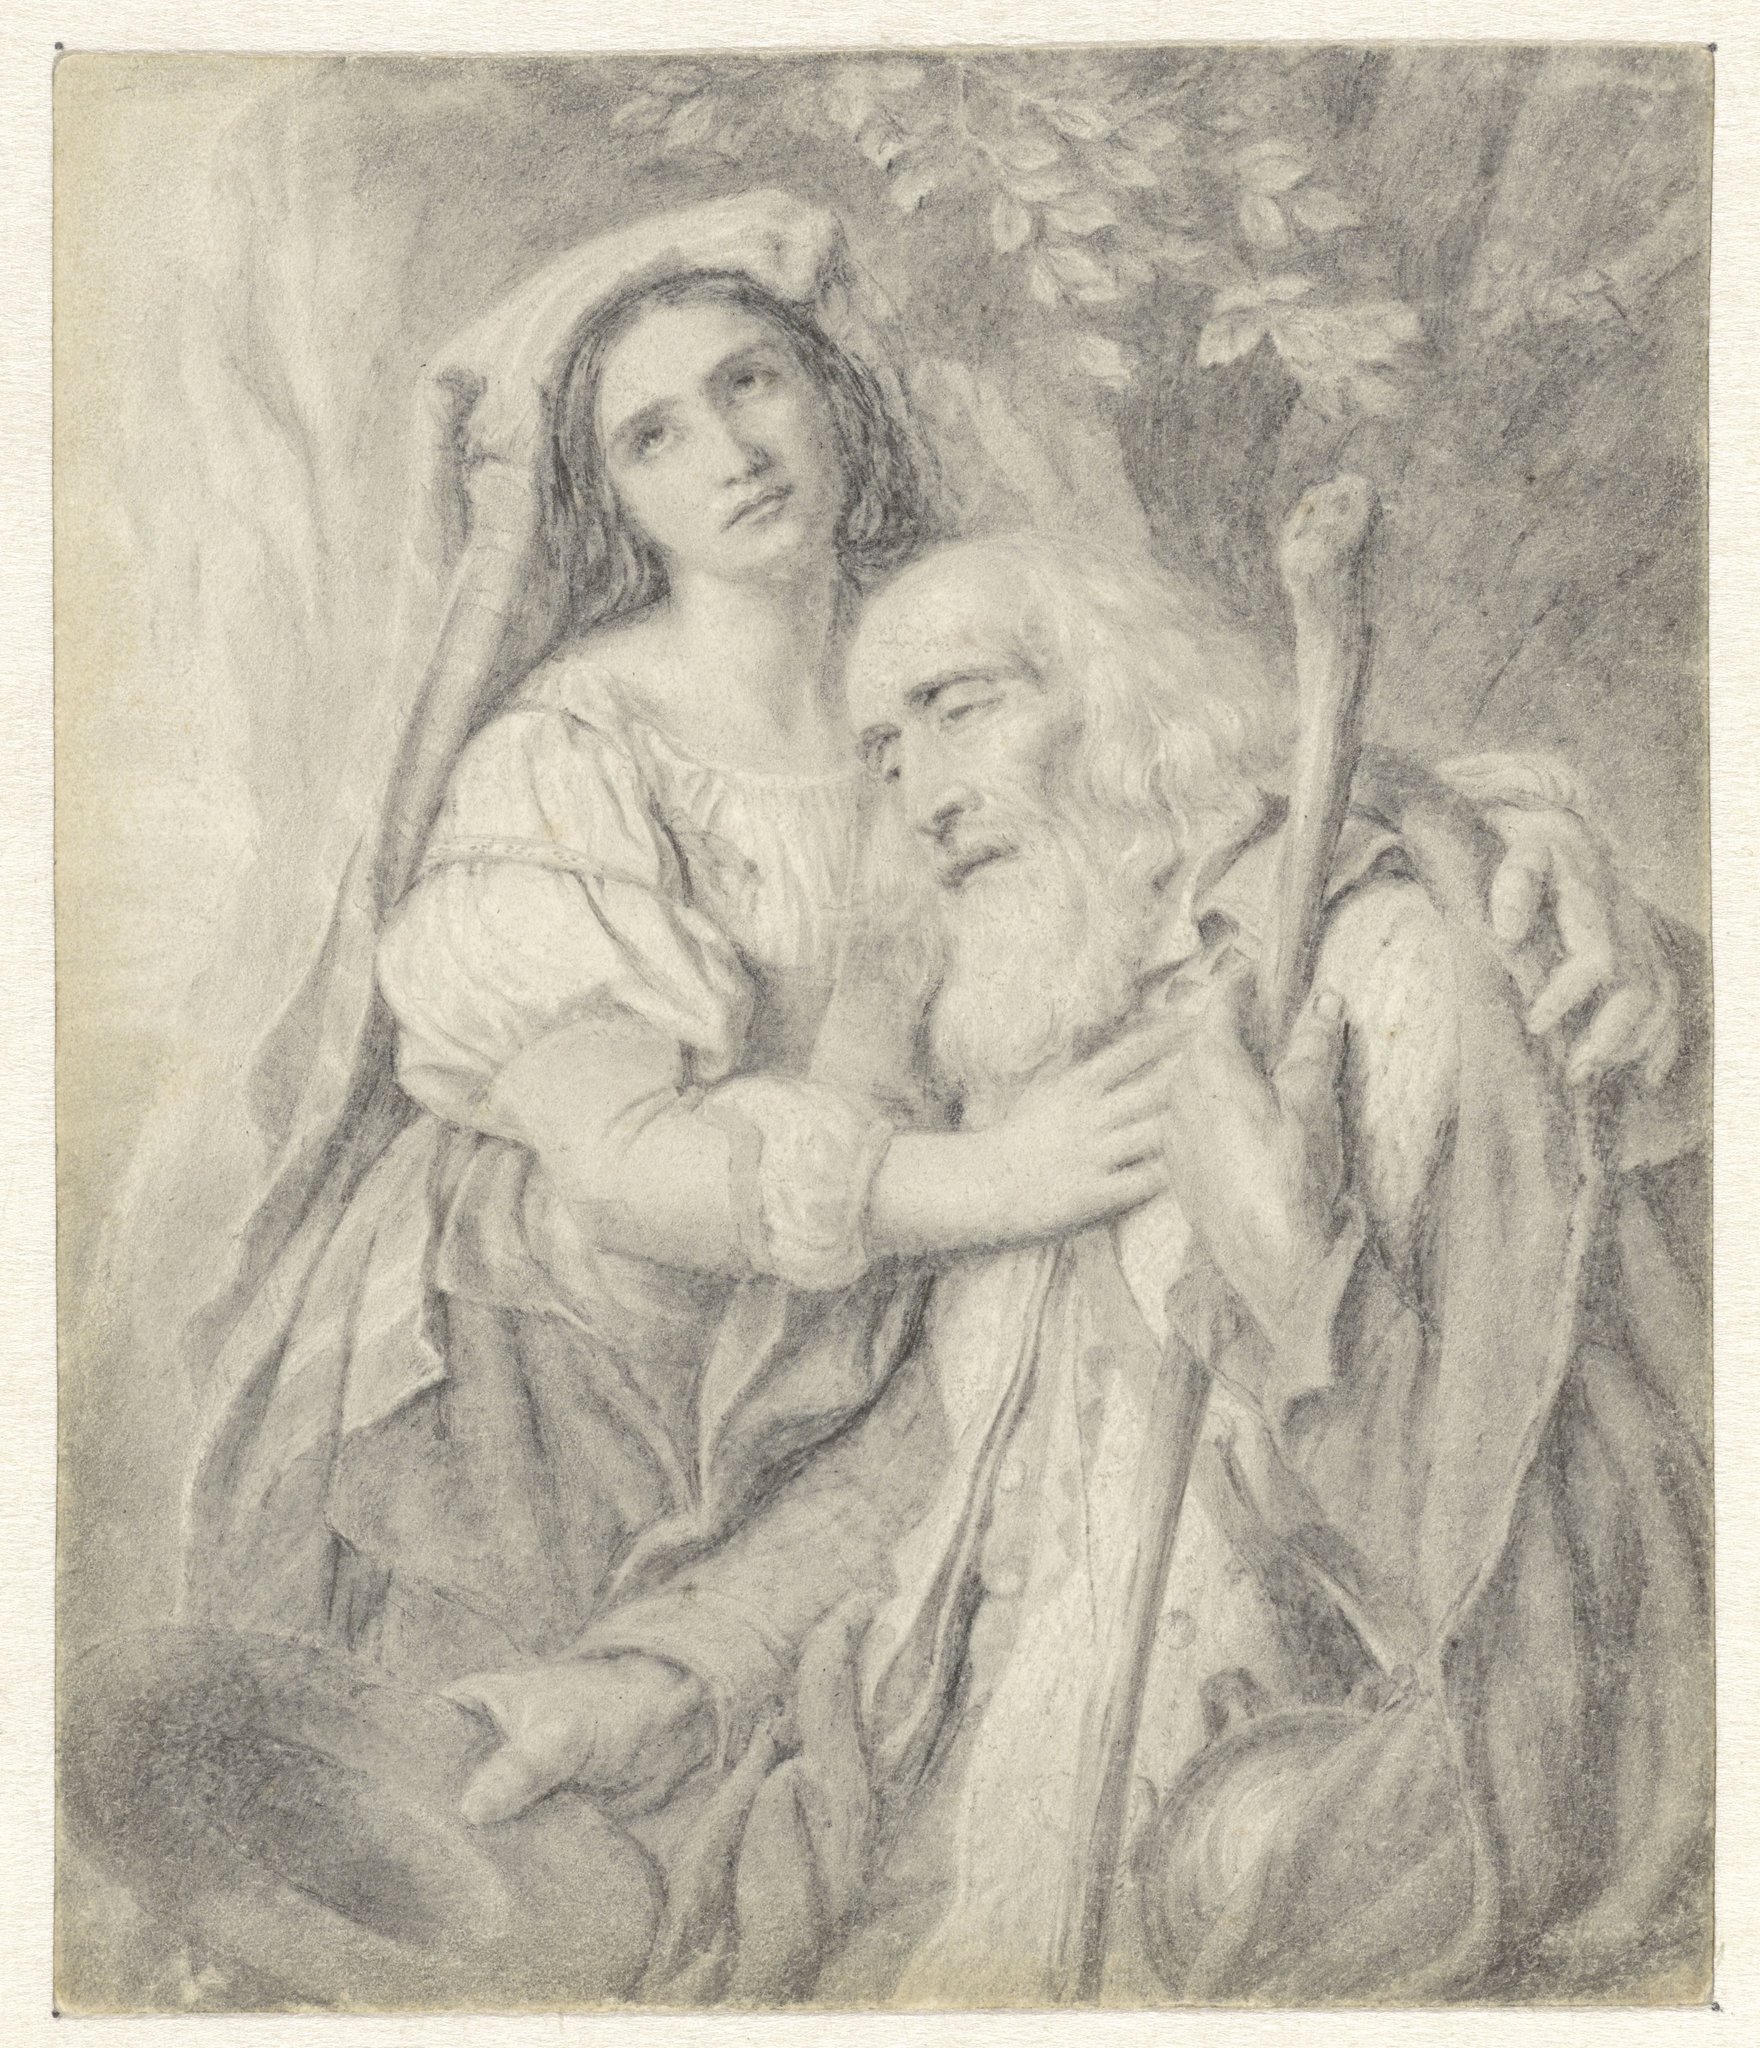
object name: drawing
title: Oude bedelaar met dochter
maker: matthijs maris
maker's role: draughtsman, painter, print maker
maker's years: 1839-1917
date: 1849-1917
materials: paper, pencil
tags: beggar